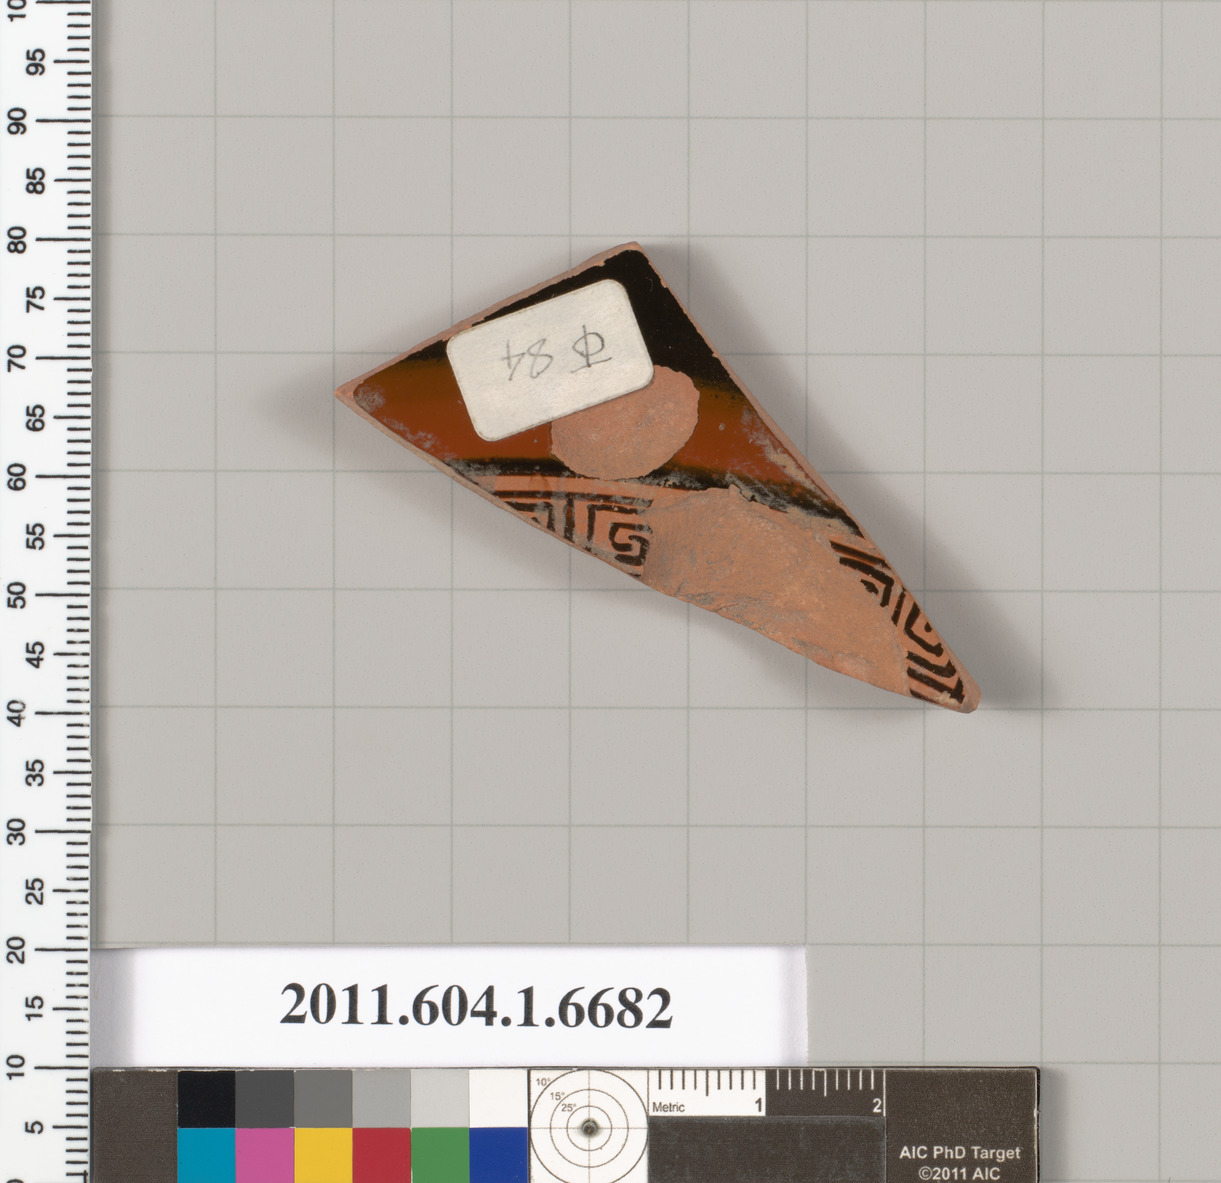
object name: kylix fragment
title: Terracotta fragment of a kylix (drinking cup)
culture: greek, attic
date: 490-470 BCE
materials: terracotta